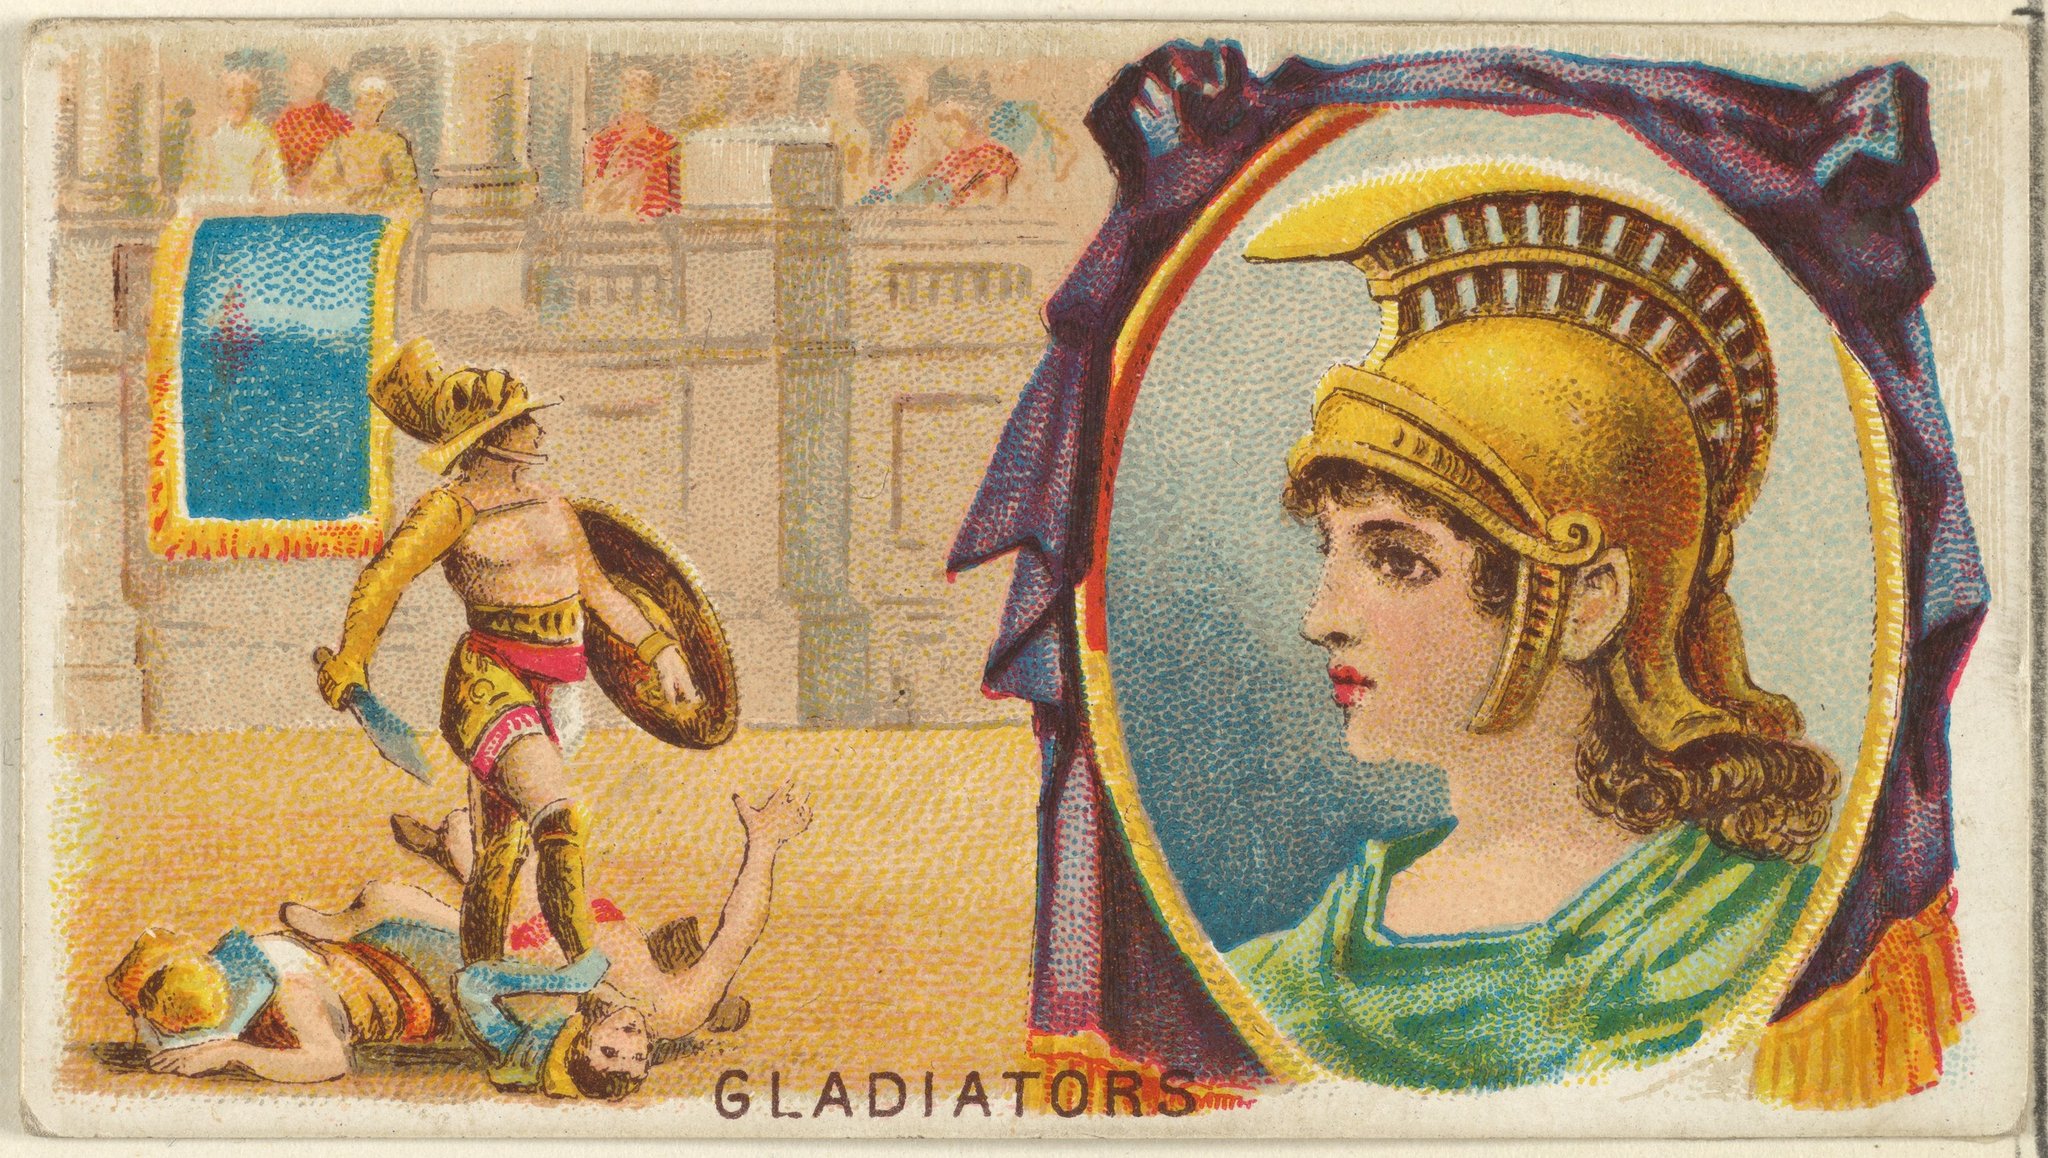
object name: print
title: Gladiators, from the Games and Sports series (N165) for Old Judge Cigarettes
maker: goodwin & company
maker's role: publisher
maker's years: 1850-1950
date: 1889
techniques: color lithograph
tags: soldiers,weapons,men,women